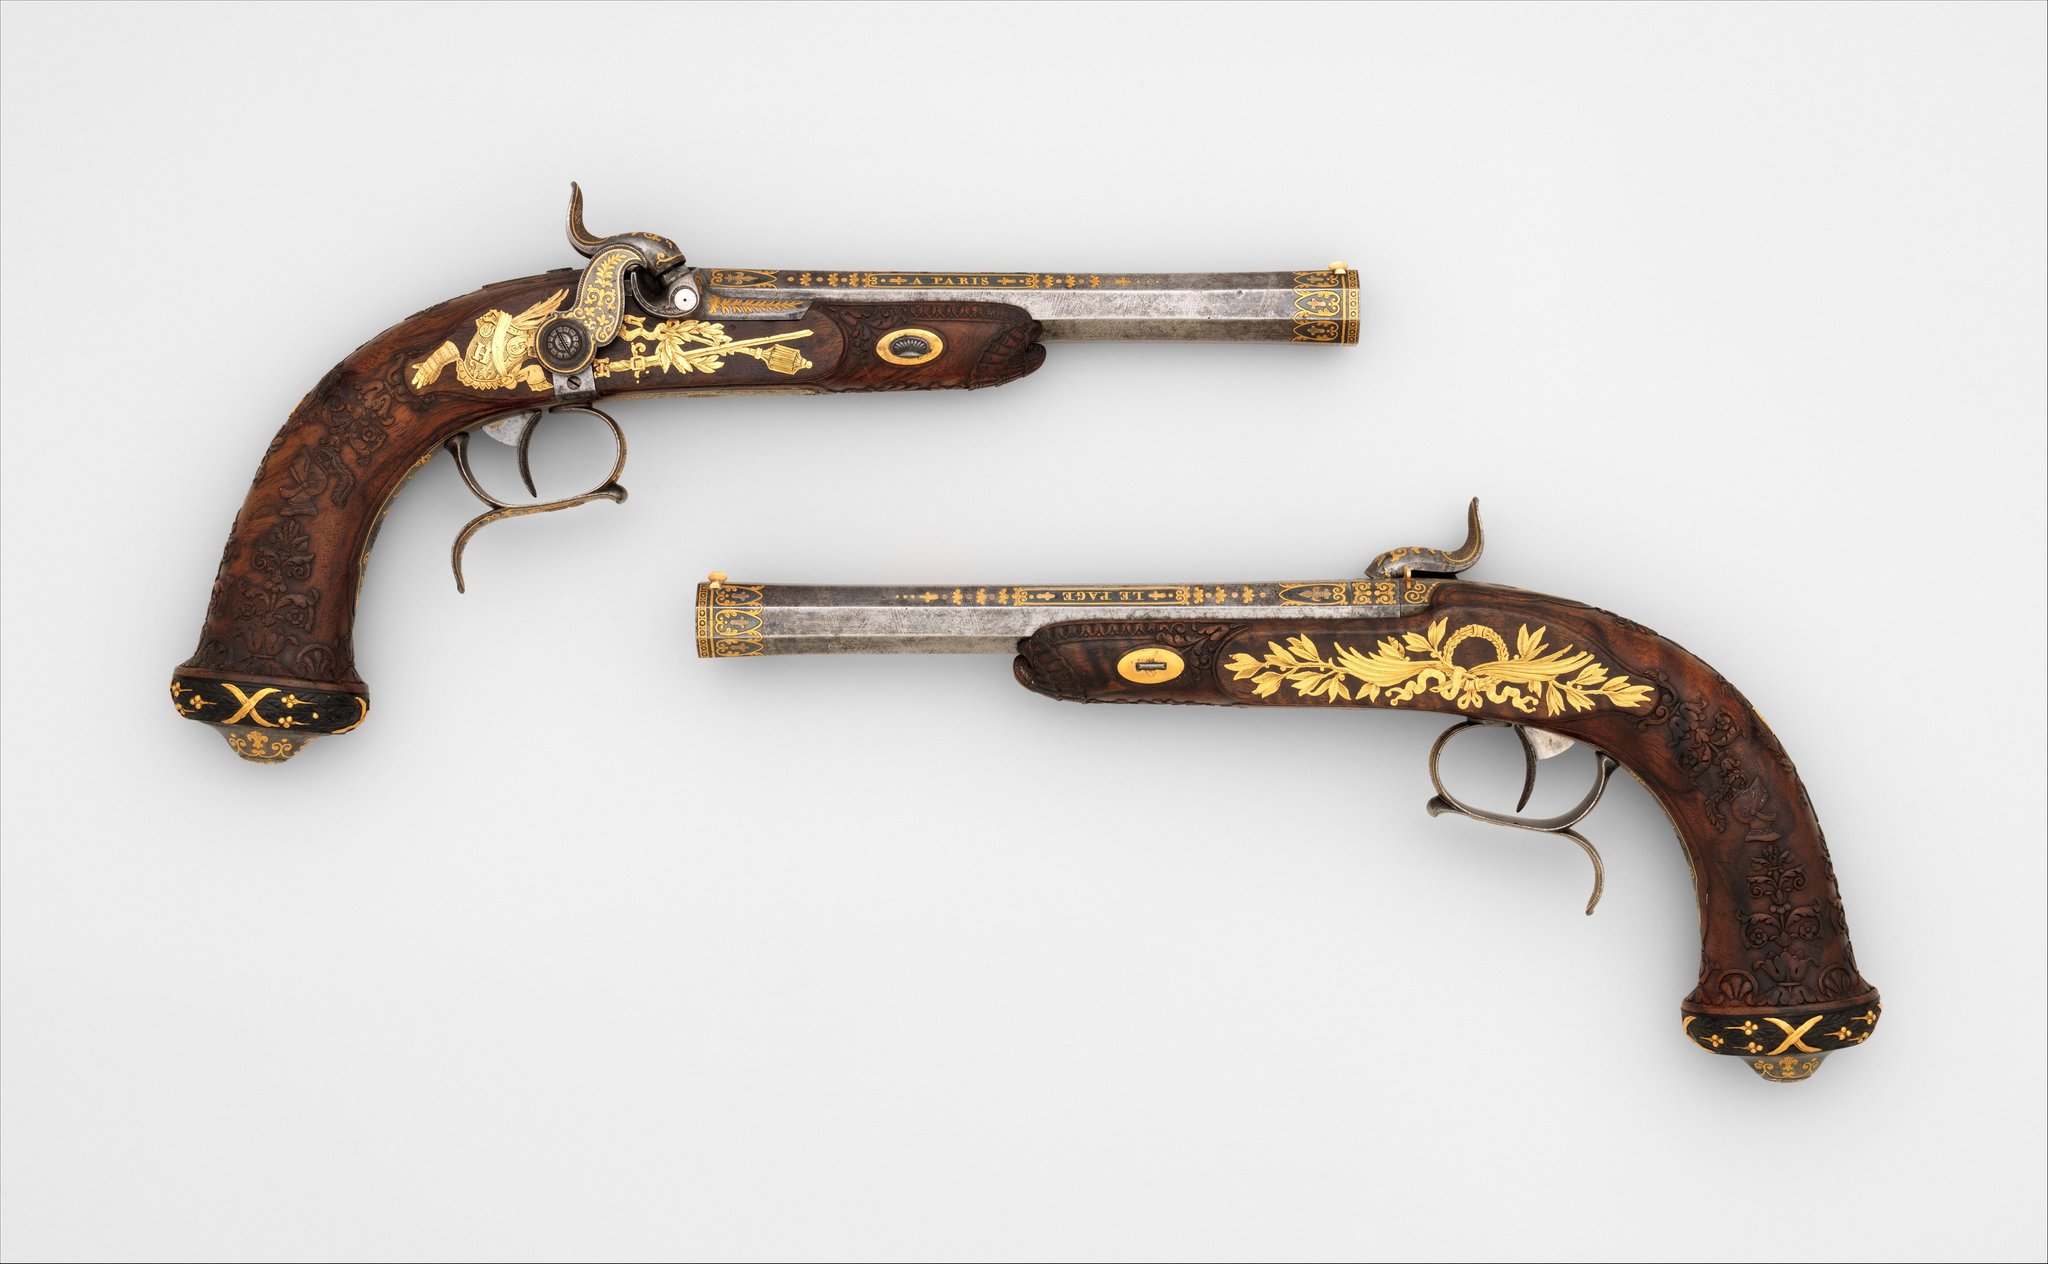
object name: cased pair of percussion target pistol with loading and cleaning accessory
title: Cased Pair of Percussion Target Pistols with Loading and Cleaning Accessories, Made for Henri Charles Ferdinand Marie Dieudonné d'Artois, Duke of Bordeaux, Count of Chambord (1820–1883)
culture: french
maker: jean andré prosper henri le page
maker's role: gunsmith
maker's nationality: french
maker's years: 1792-1854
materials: gold, ivory, silver, steel, velvet, wood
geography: france